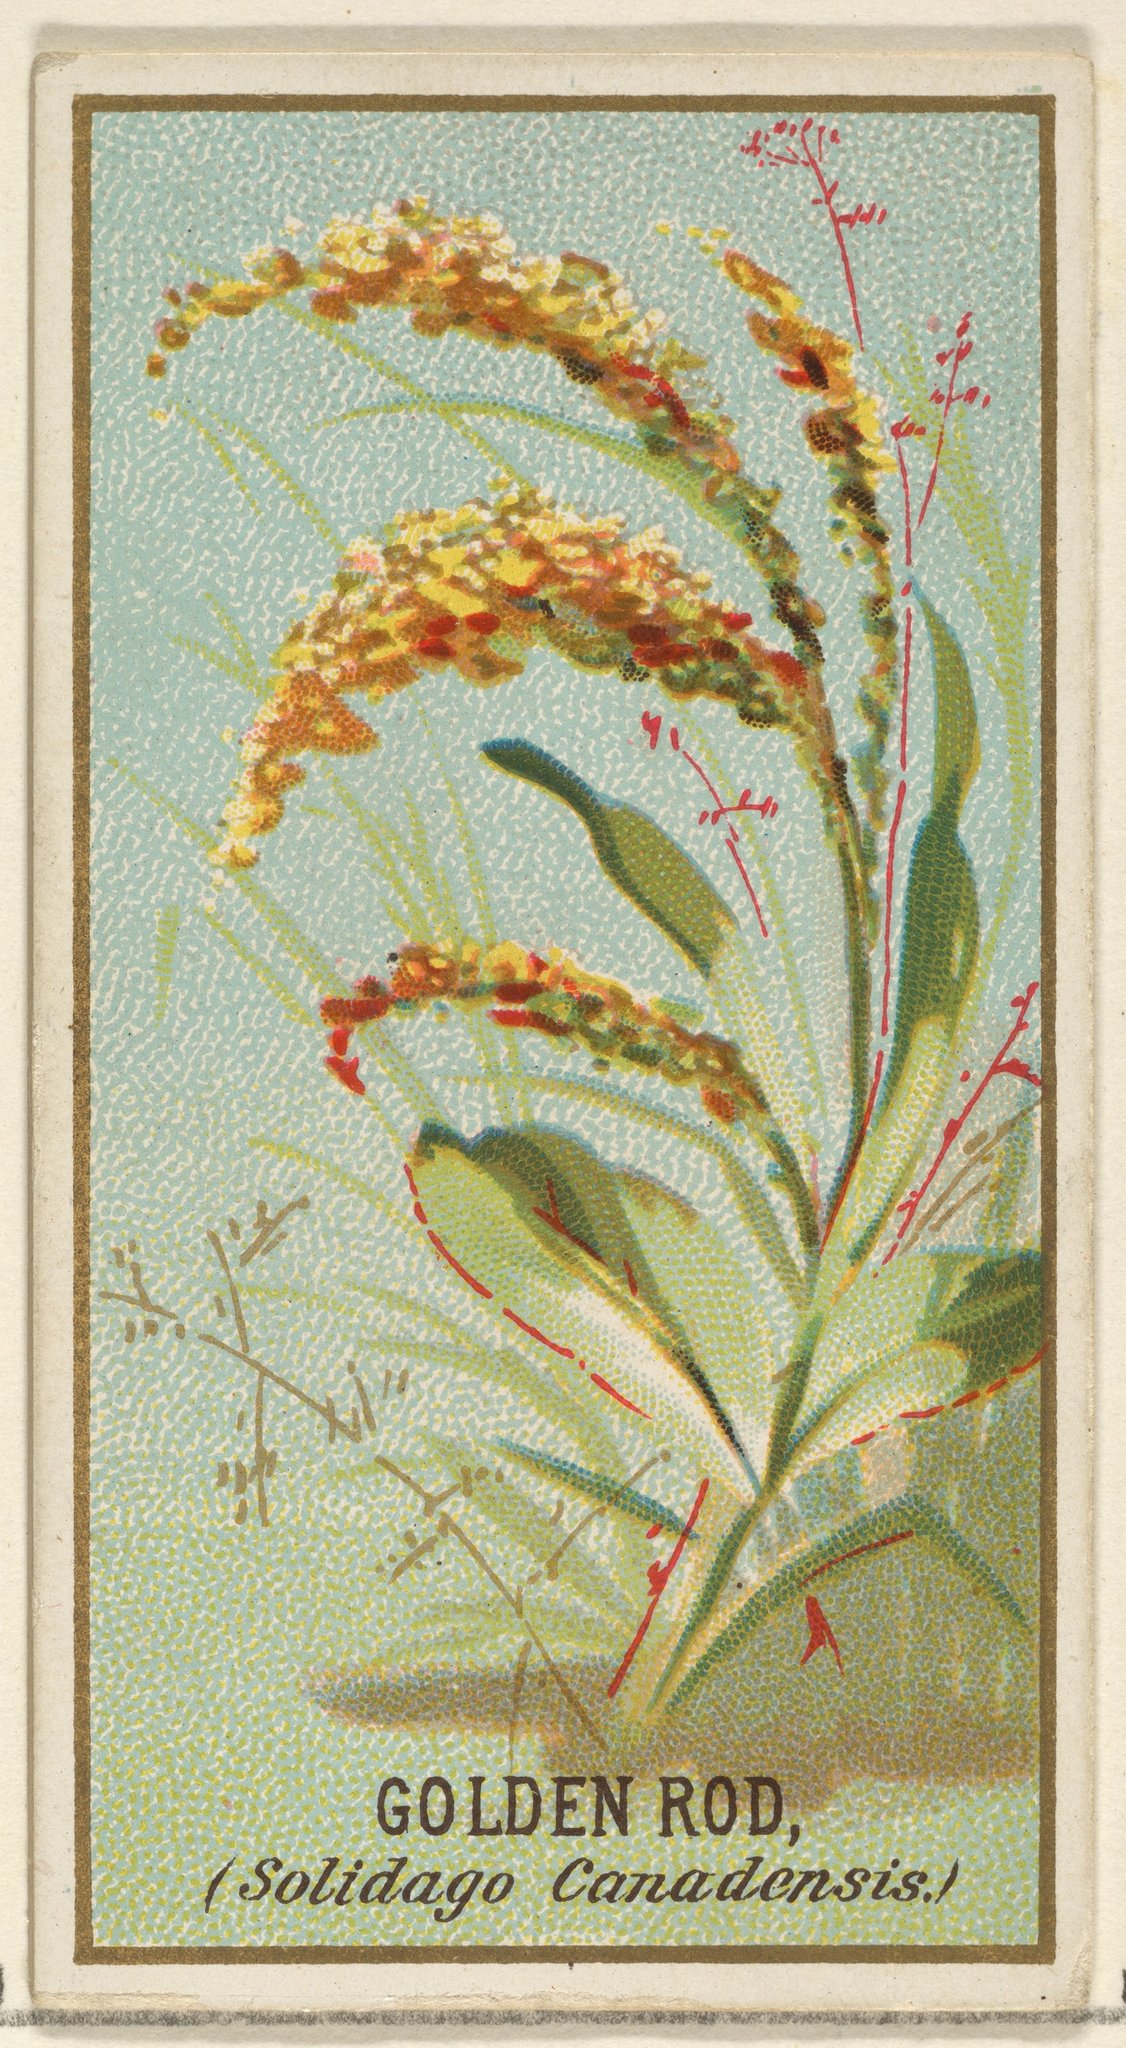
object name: print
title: Golden Rod (Solidago Canadensis), from the Flowers series for Old Judge Cigarettes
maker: goodwin & company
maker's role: publisher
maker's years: 1850-1950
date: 1890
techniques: color lithograph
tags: plants